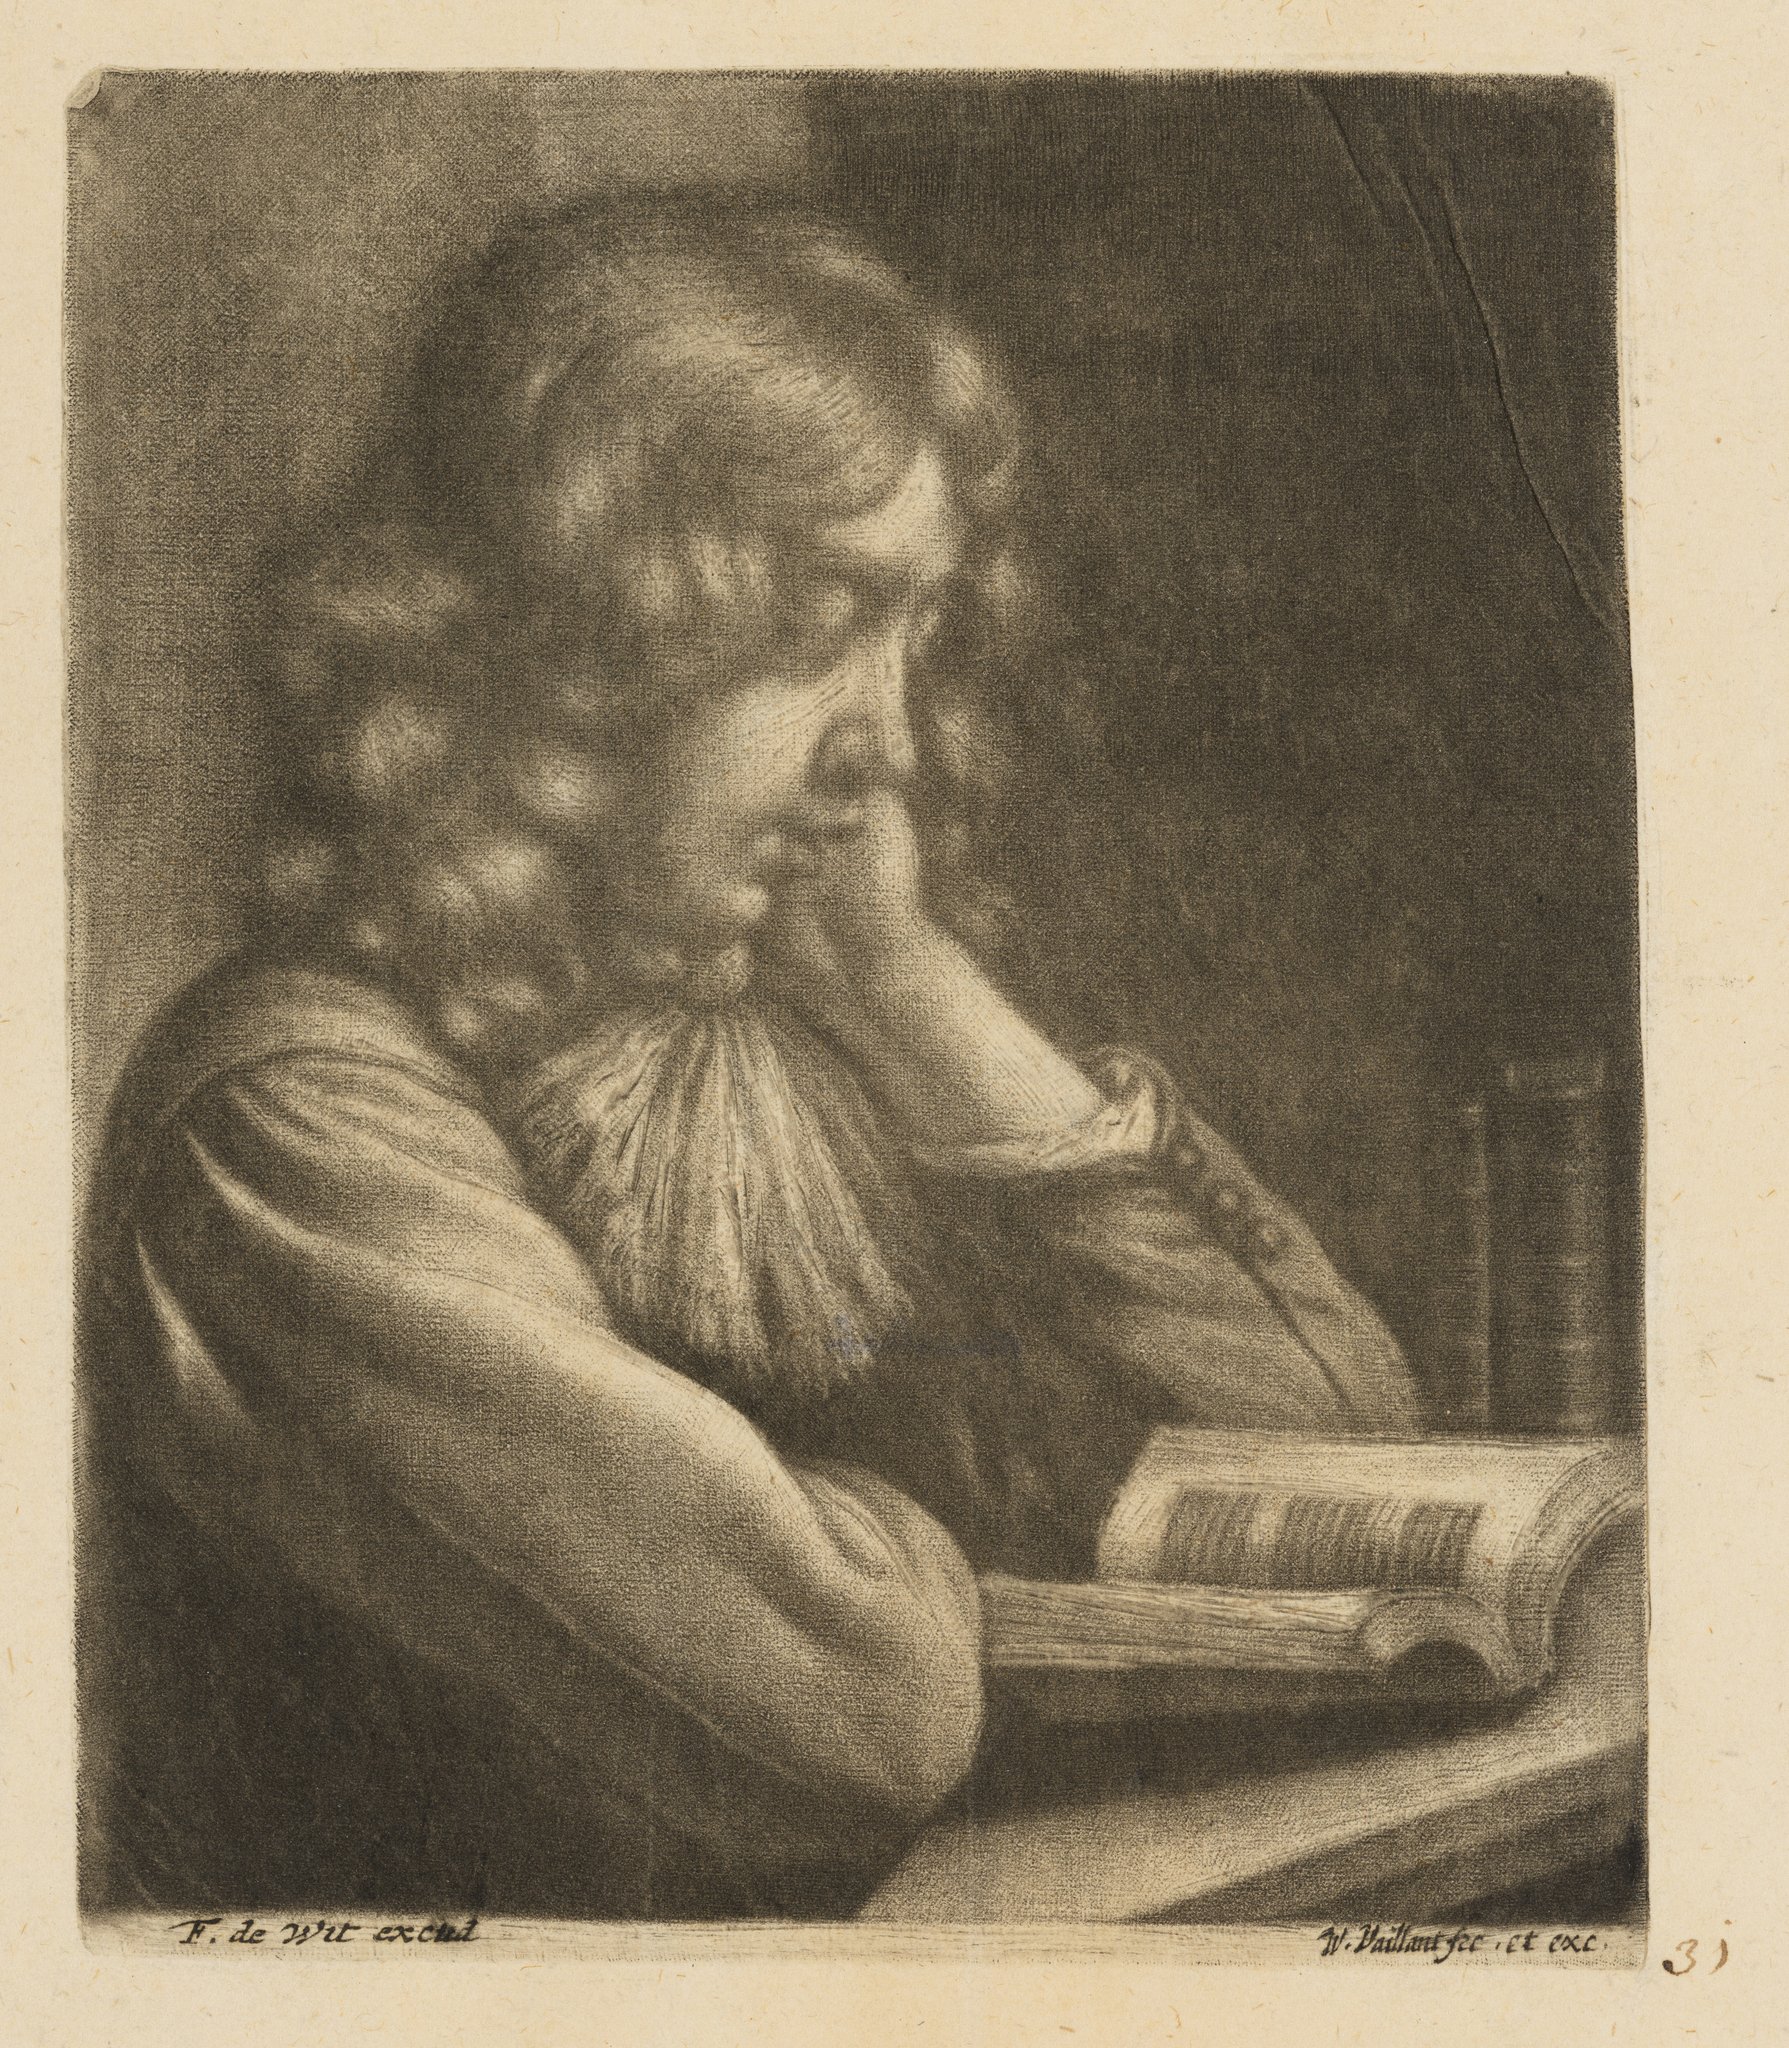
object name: print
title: Boy Reading a Book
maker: wallerant vaillant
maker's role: artist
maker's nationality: dutch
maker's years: 1623-1677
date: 1634-1666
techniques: mezzotint